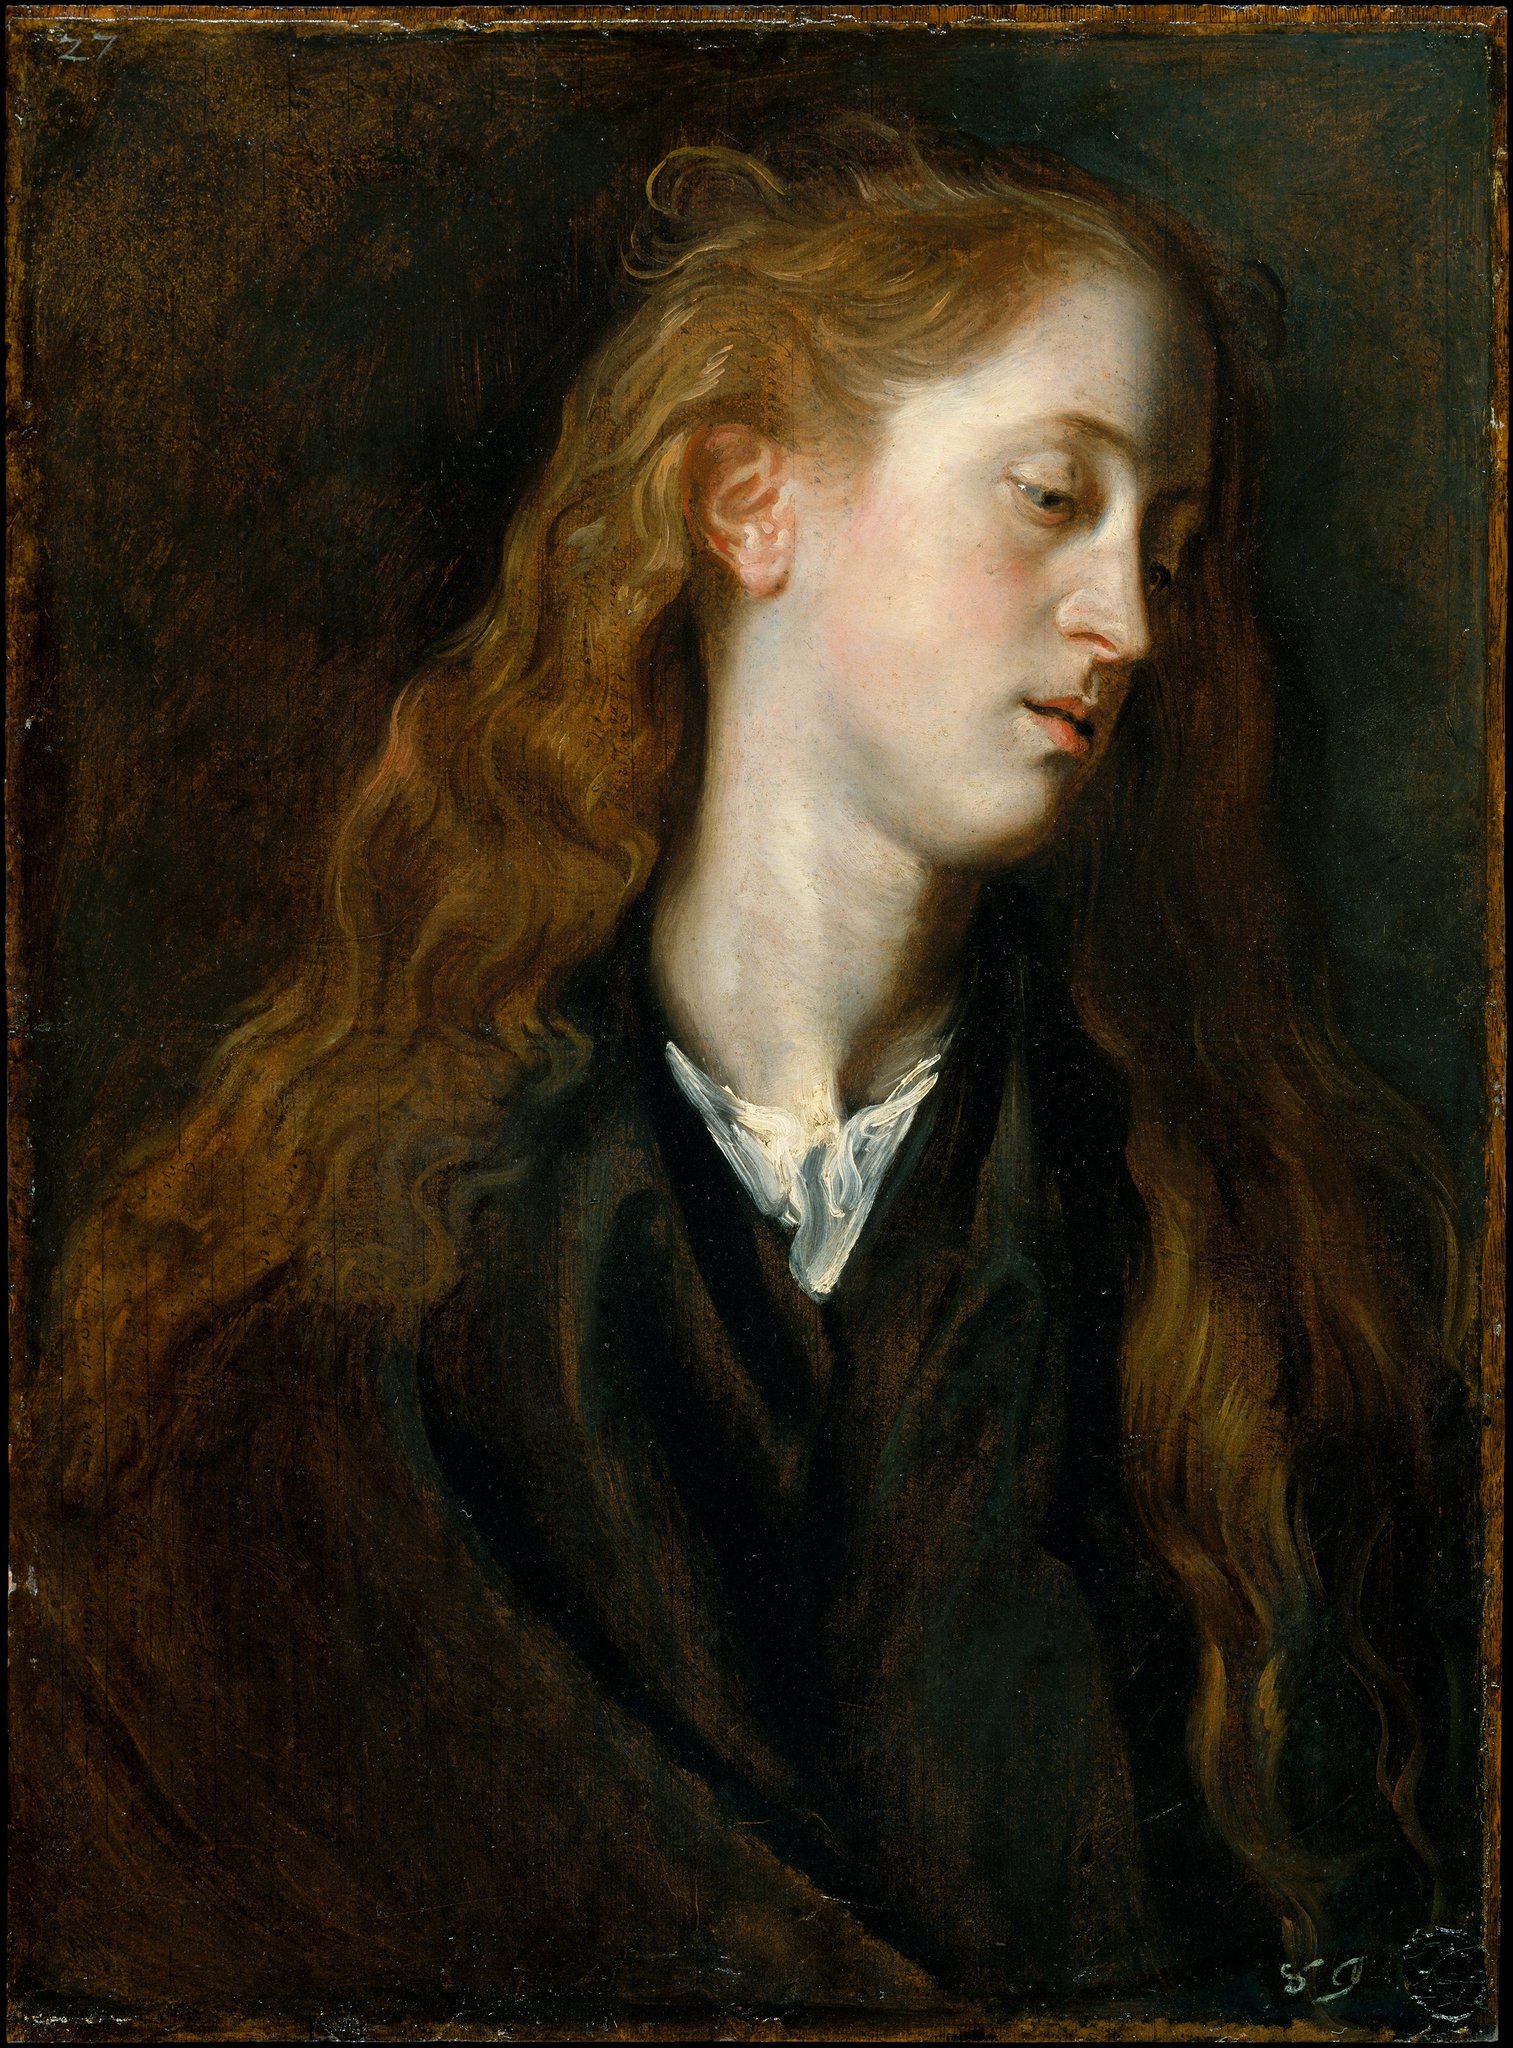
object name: painting, drawing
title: Study Head of a Young Woman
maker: anthony van dyck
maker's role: artist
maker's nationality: flemish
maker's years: 1599-1641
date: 1618-1620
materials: oil, paper, wood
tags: portraits,women